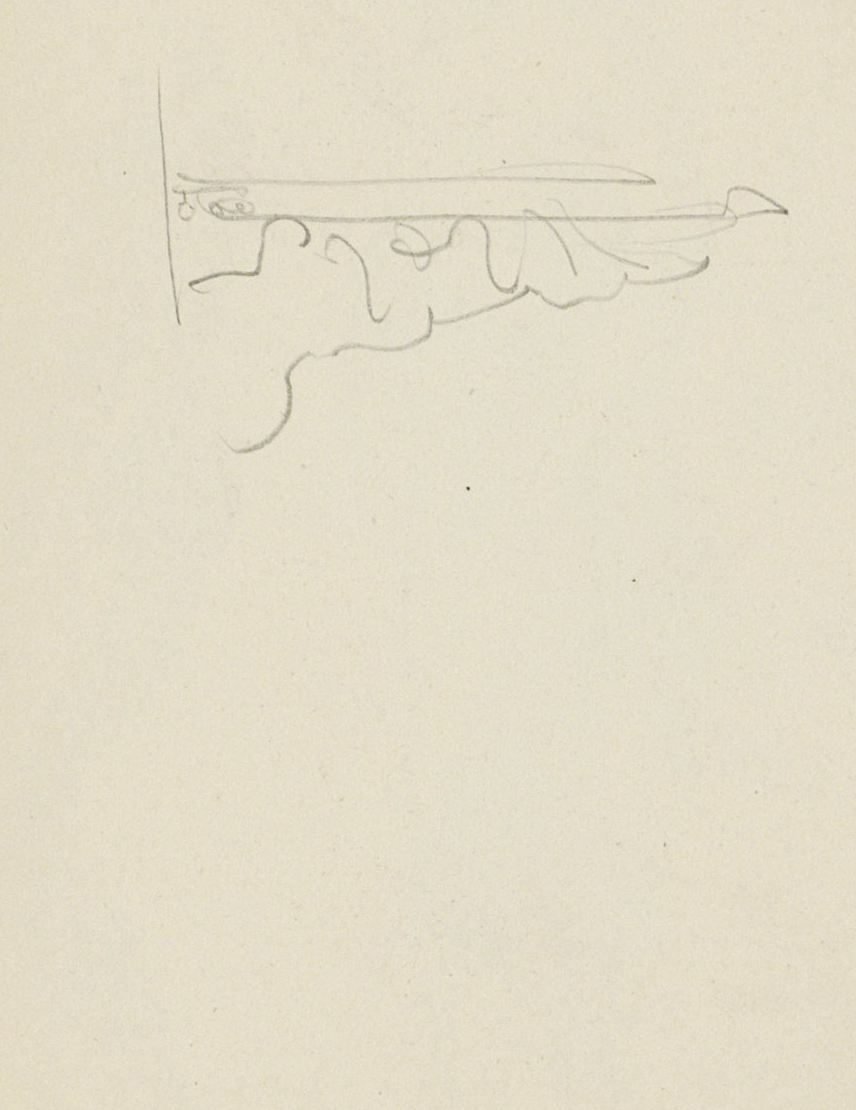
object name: sketchbook leaf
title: Studie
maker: reijer stolk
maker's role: draughtsman, print maker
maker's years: 1896-1945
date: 1906-1945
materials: paper, pencil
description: Blad 9 verso uit een schetsboek met 69 bladen.